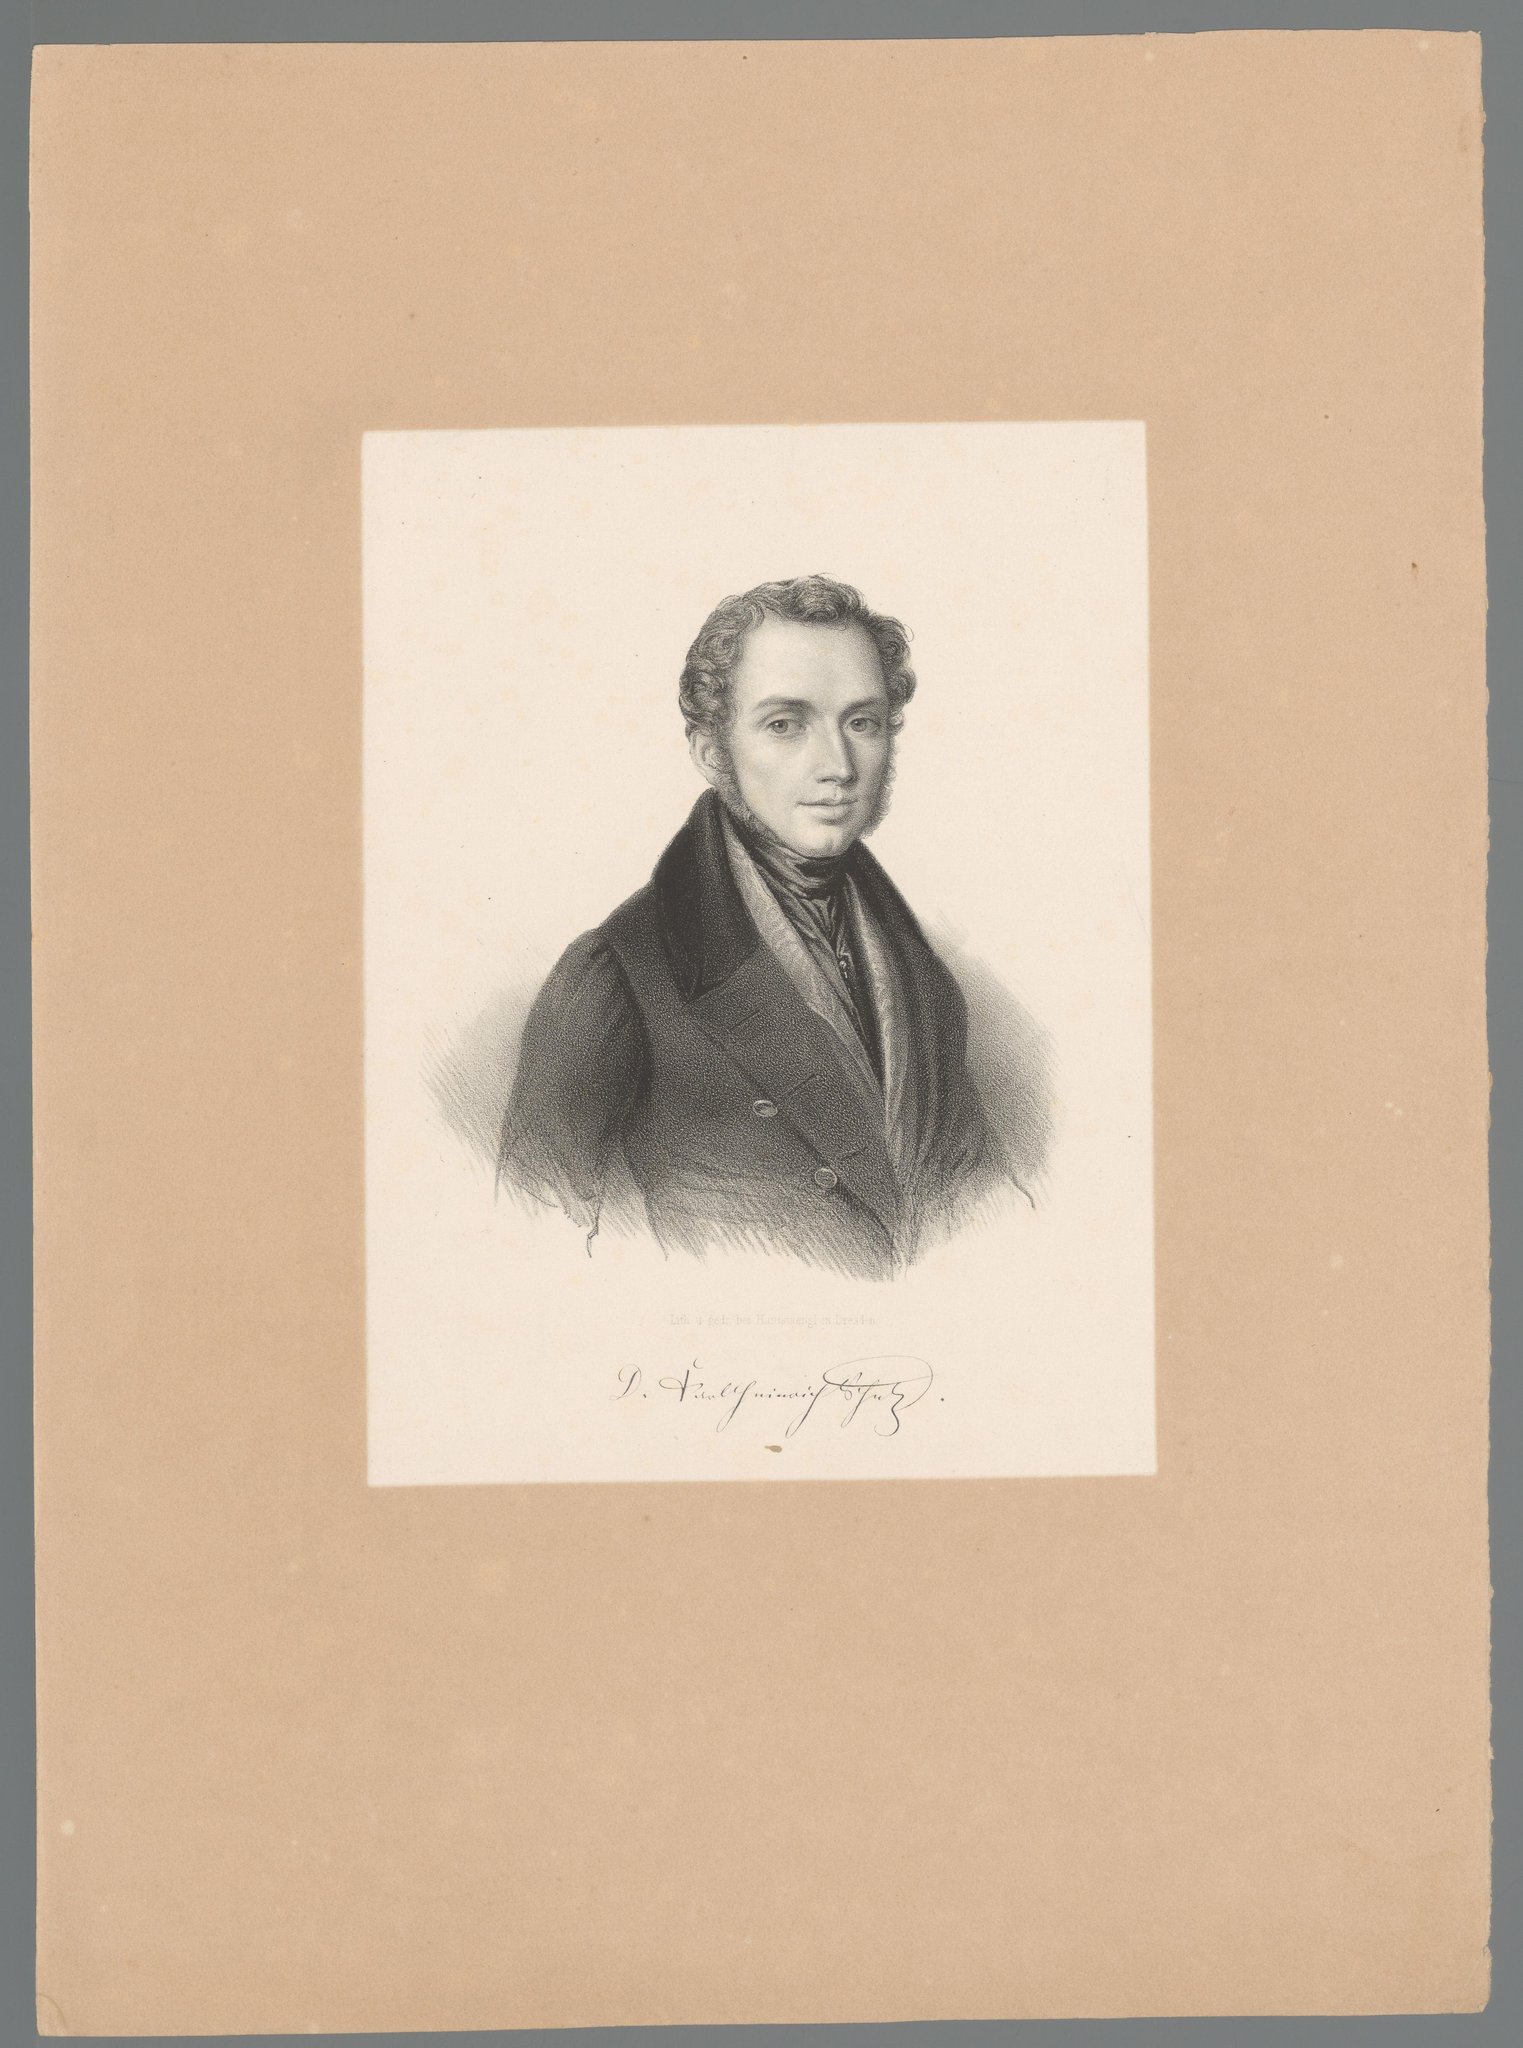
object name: print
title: Portret van een onbekende man, mogelijk Karl Heinrich Schulz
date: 1814-1877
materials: paper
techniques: lithograph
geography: dresden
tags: adult man, historical persons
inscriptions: collector's mark: Lugt 2228